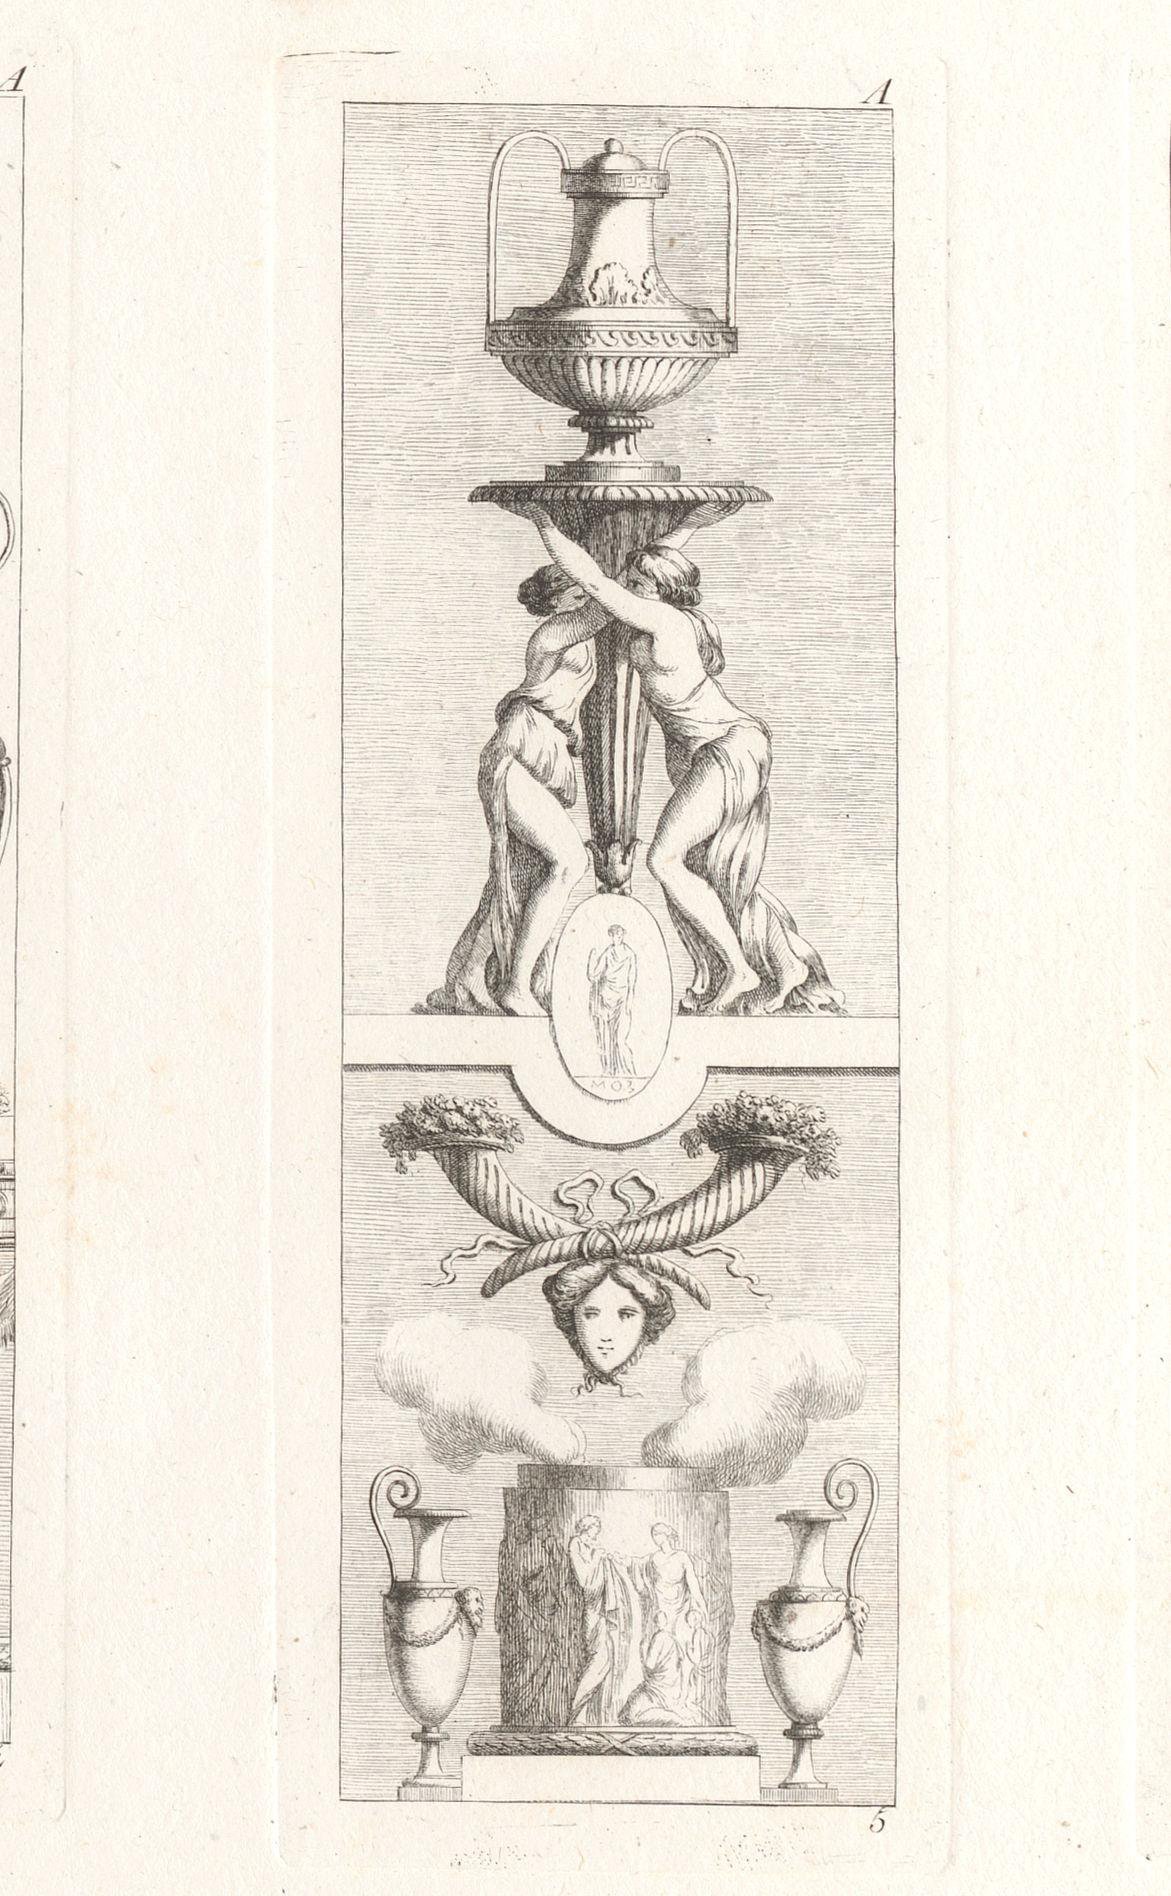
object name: album leaf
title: Verzameling van arabesken, met de Vaticaanse loggia's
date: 1802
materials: paper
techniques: etching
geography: paris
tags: 'cornucopia', horn of plenty, altar ~ non-christian religions, ornament ~ arabesque, mask, mascaron ~ ornament, ornamental fountain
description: Doordat dit album bestaat uit meerdere, deels eerder uitgegeven prentreeksen, is de datering niet consequent. Het geheel is op de titelpagina gedateerd op 1802. Deze reeks is niet los gedateerd. De serietitel voor het gehele werk is "Recueil d'arabesques, contenant les loges du Vatican". De andere serietitel is de titel van de specifieke reeks binnen het geheel.